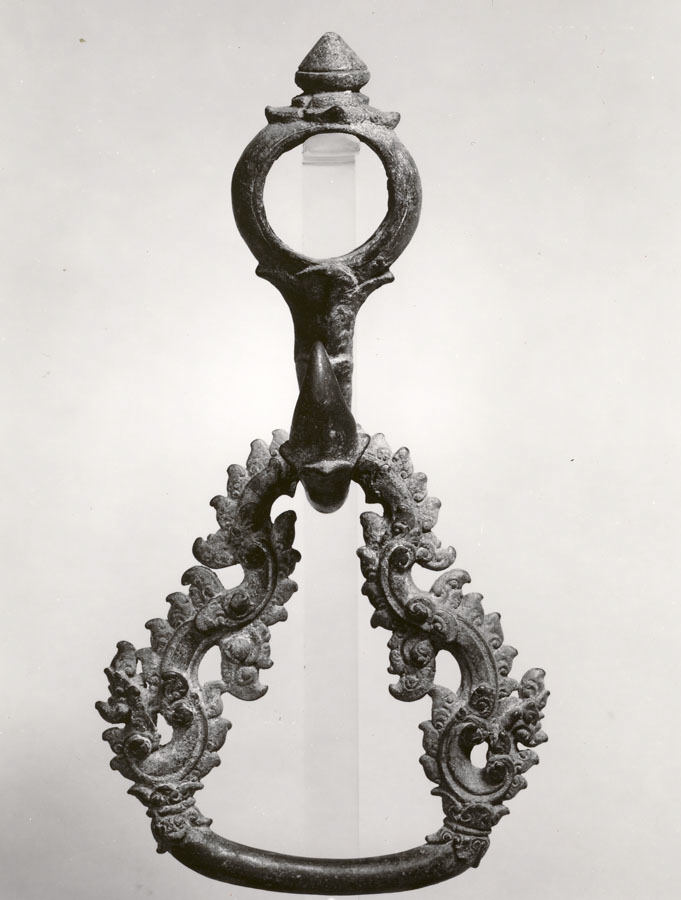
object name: palanquin hook and ring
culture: cambodian or thai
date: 1201-1300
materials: bronze